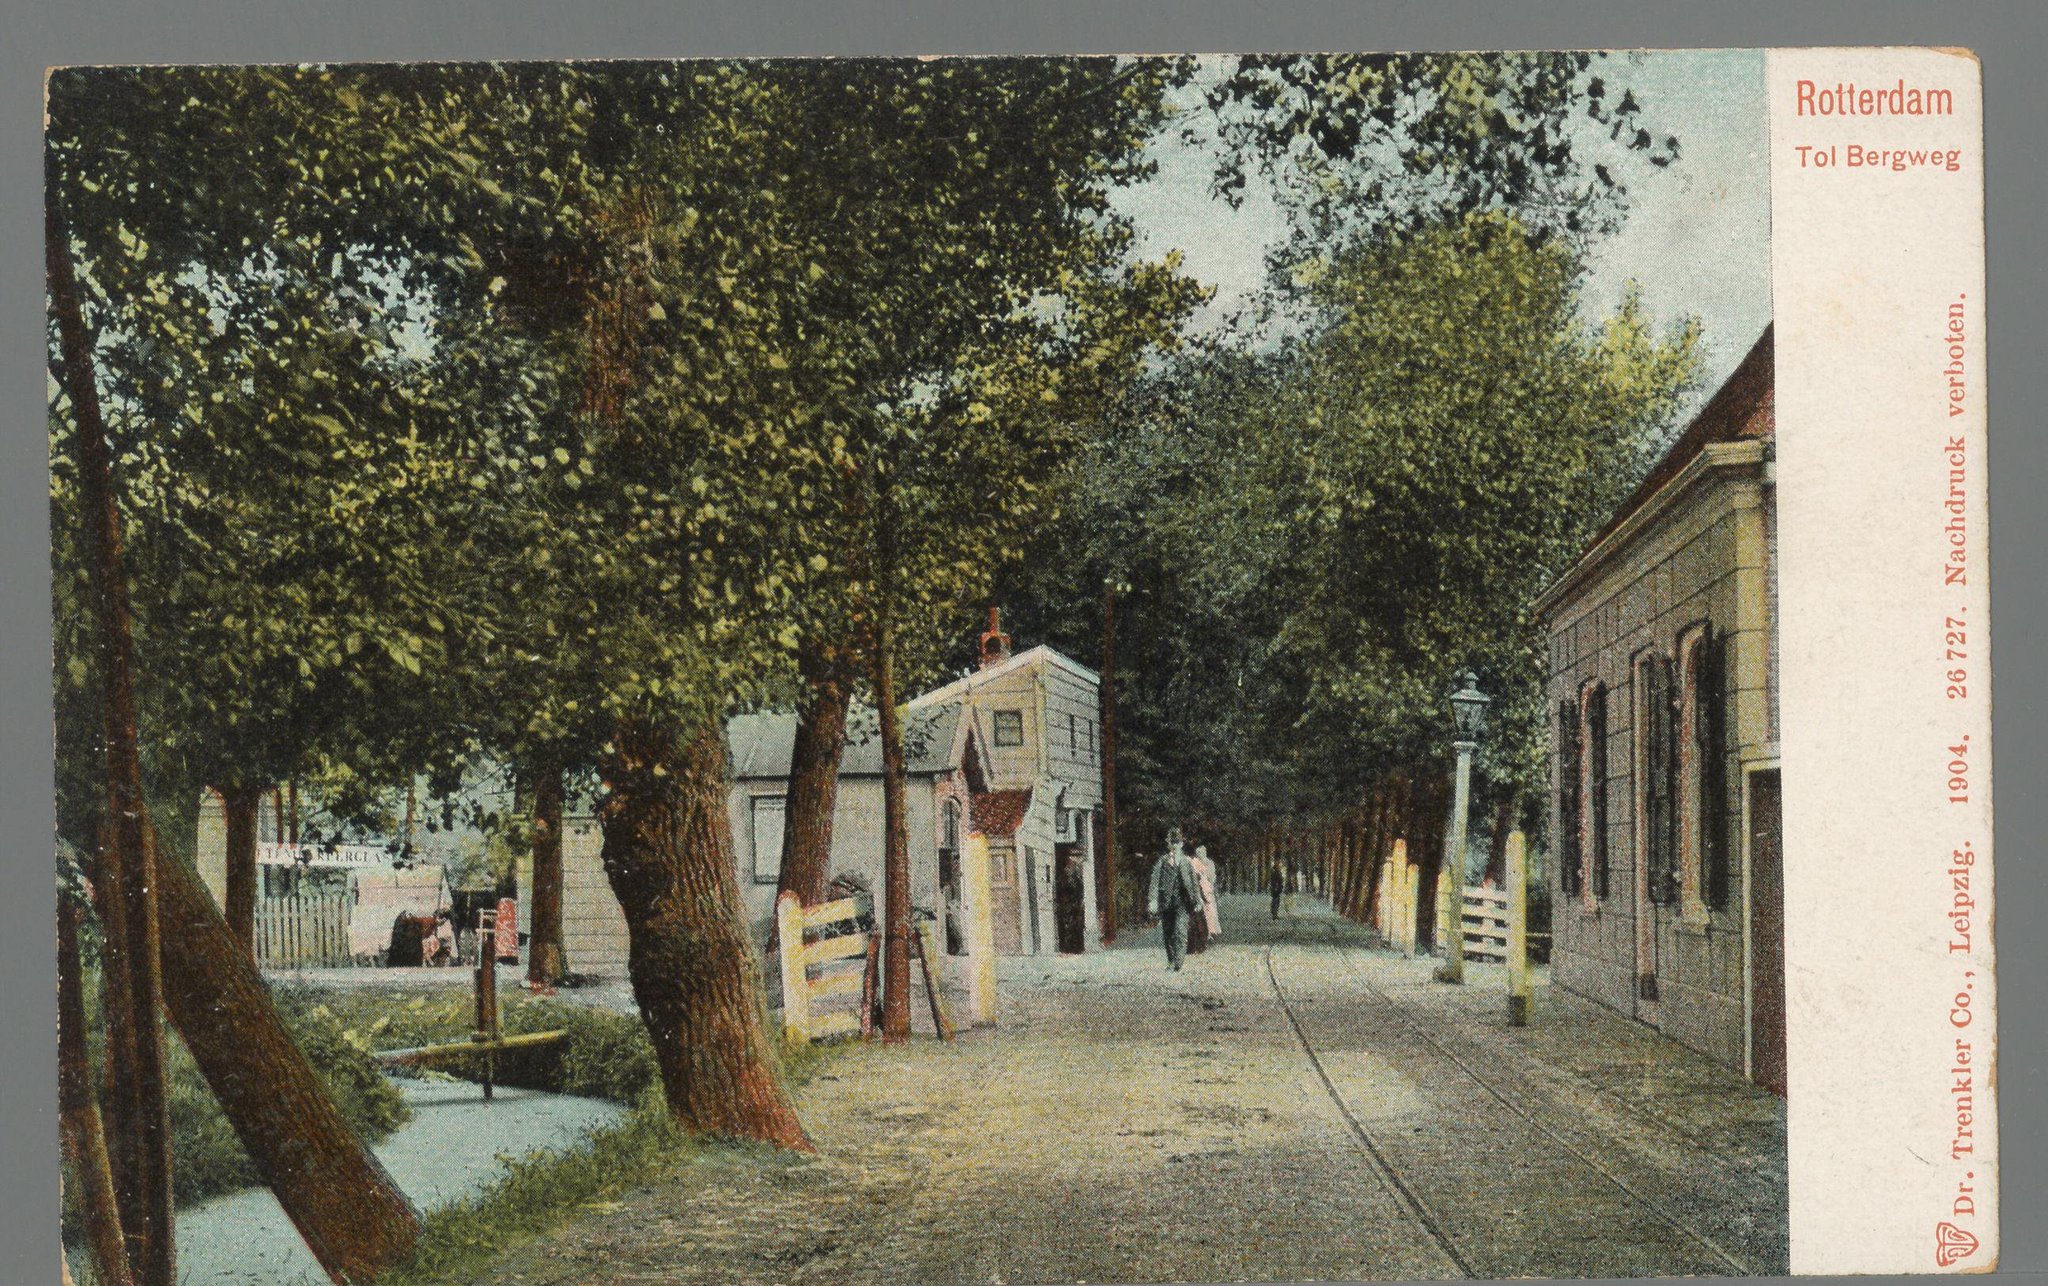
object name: photomechanical print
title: Rotterdam. Tol Bergweg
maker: Anonymous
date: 1904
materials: cardboard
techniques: lithograph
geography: leipzig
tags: toll gate, street, rotterdam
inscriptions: date